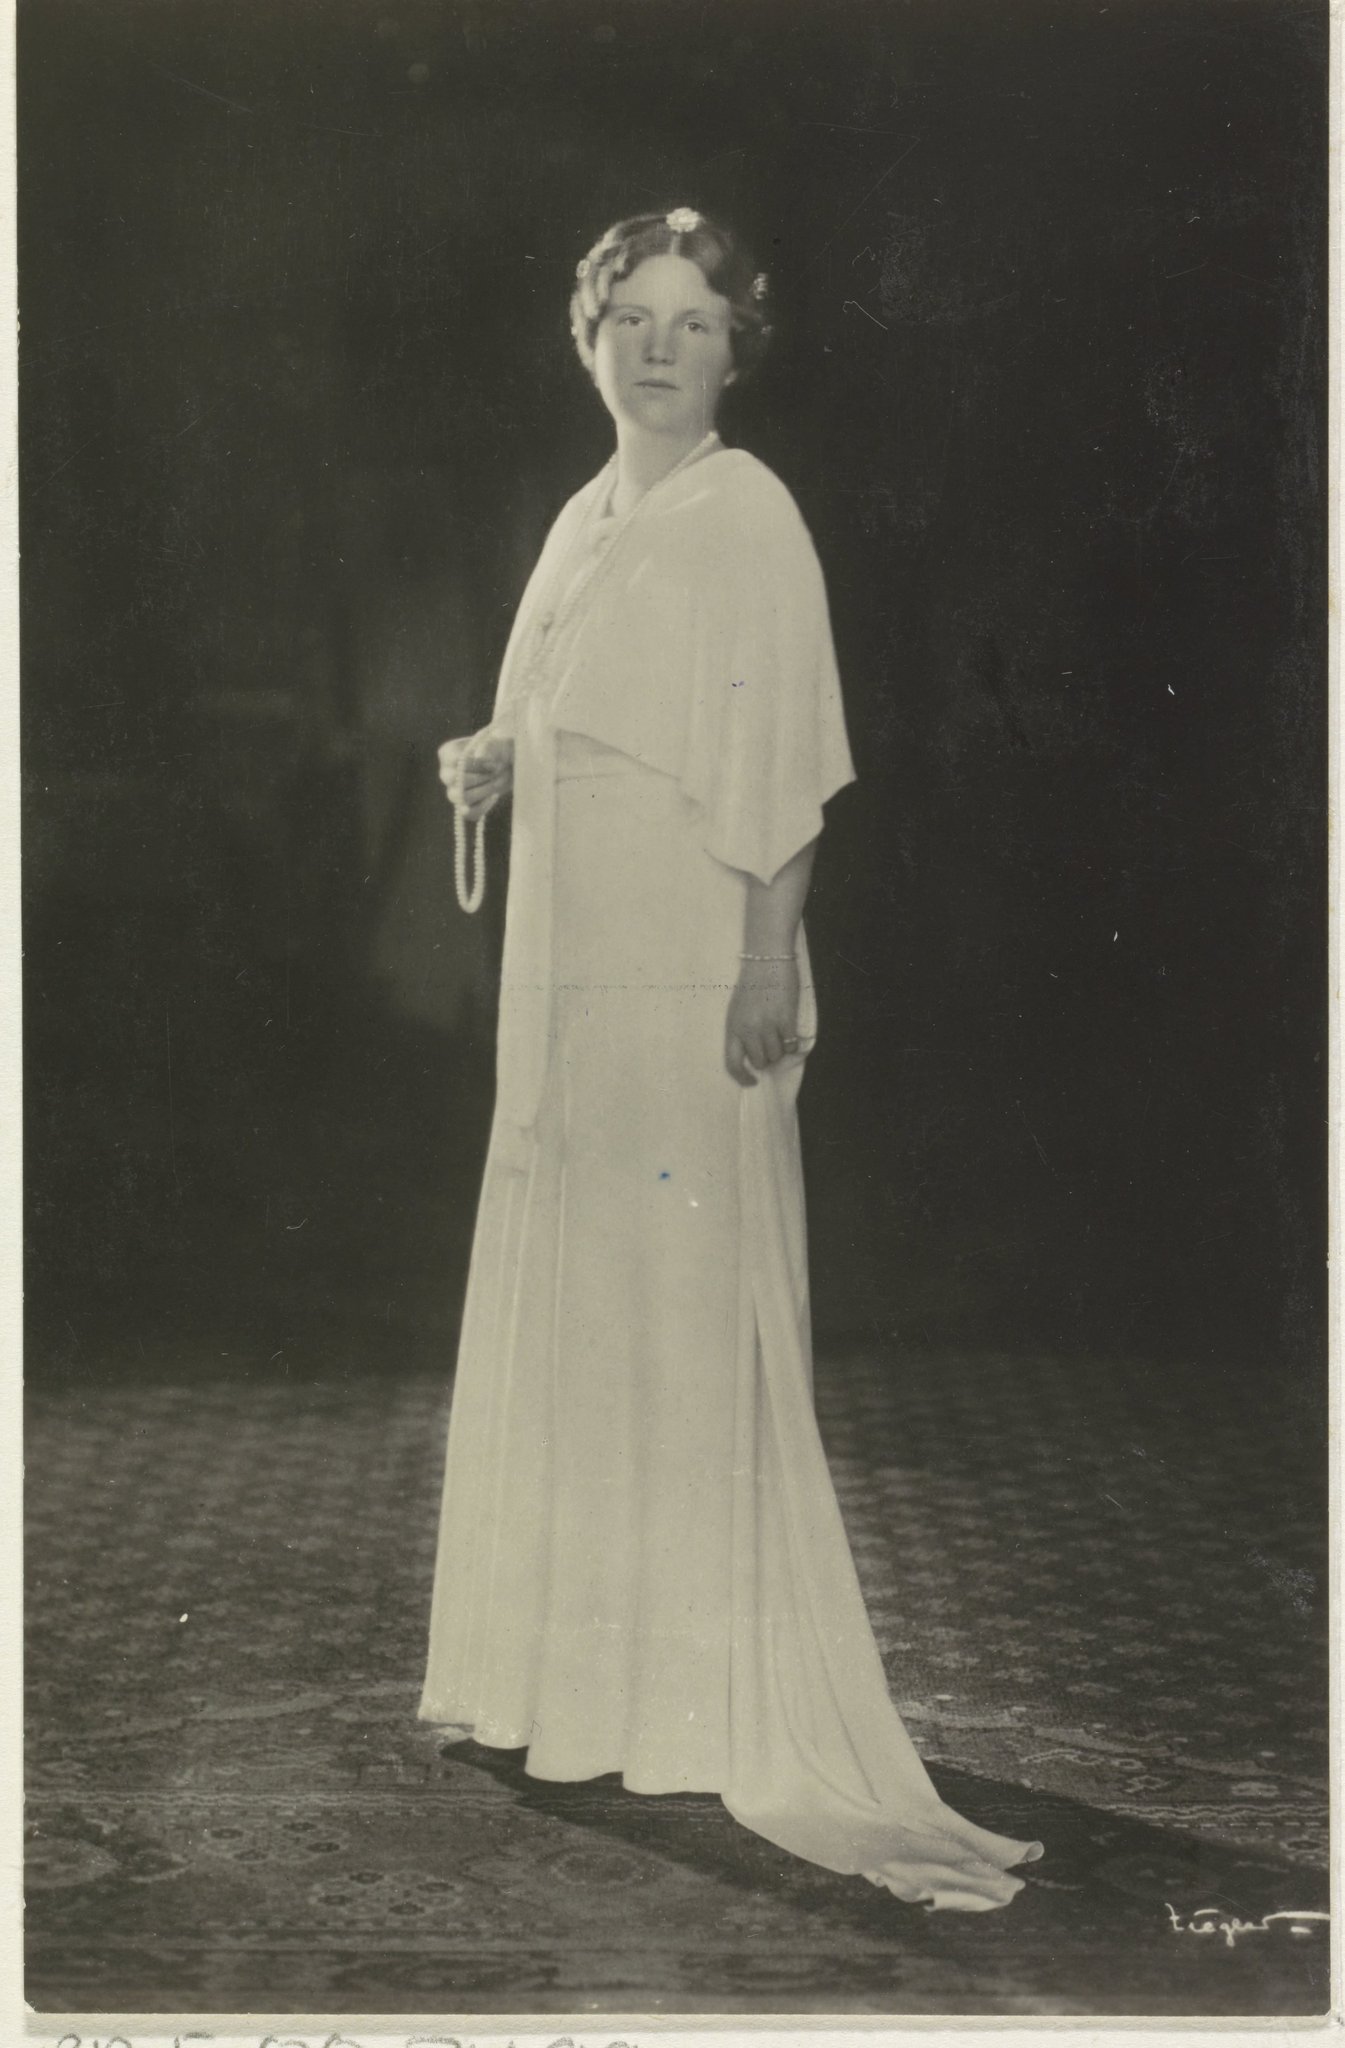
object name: photograph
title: Portret van Juliana, koningin der Nederlanden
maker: franz ziegler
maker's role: fotograaf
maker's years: 1893-1939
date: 1934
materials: photographic support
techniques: photography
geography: amsterdam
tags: juliana of the netherlands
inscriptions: address: ‘BOEKH. LANKAMP & BRINKMAN AMSTERDAM-C. SPIEGELGRACHT’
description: De hier vermelde titel verwijst naar de hoogst verkregen titel van de geportretteerde, niet per se naar de titel die de geportretteerde op deze voorstelling draagt.